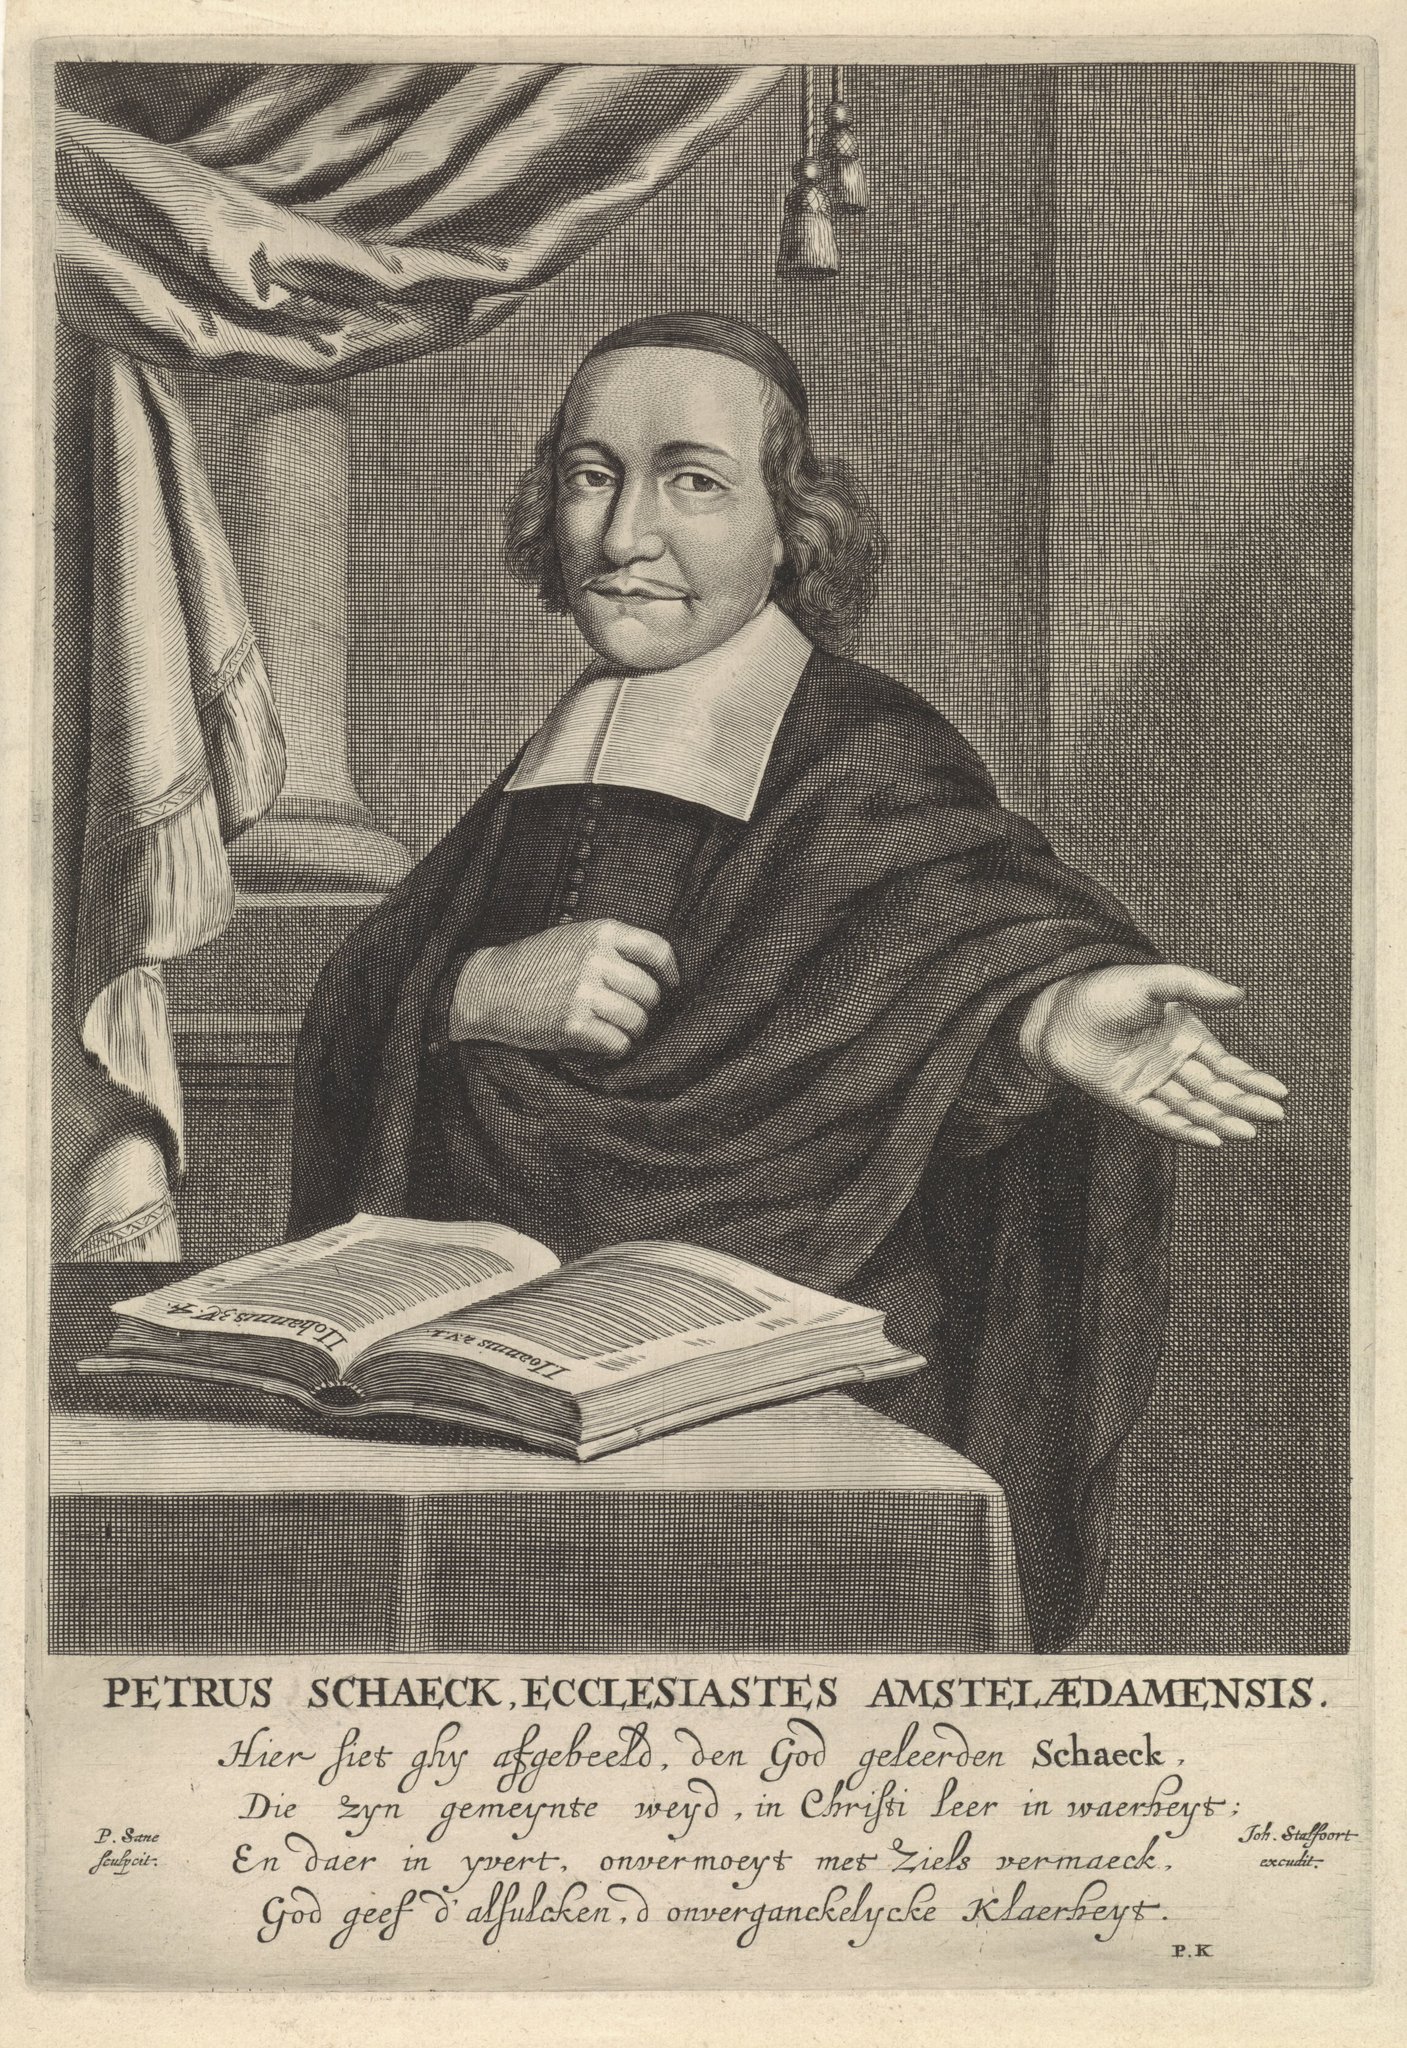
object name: print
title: Portret van de Amsterdamse predikant Petrus Schaeck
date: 1668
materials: paper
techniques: engraving, etching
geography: amsterdam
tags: predikant, petrus schaeck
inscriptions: collector's mark: Lugt 2228